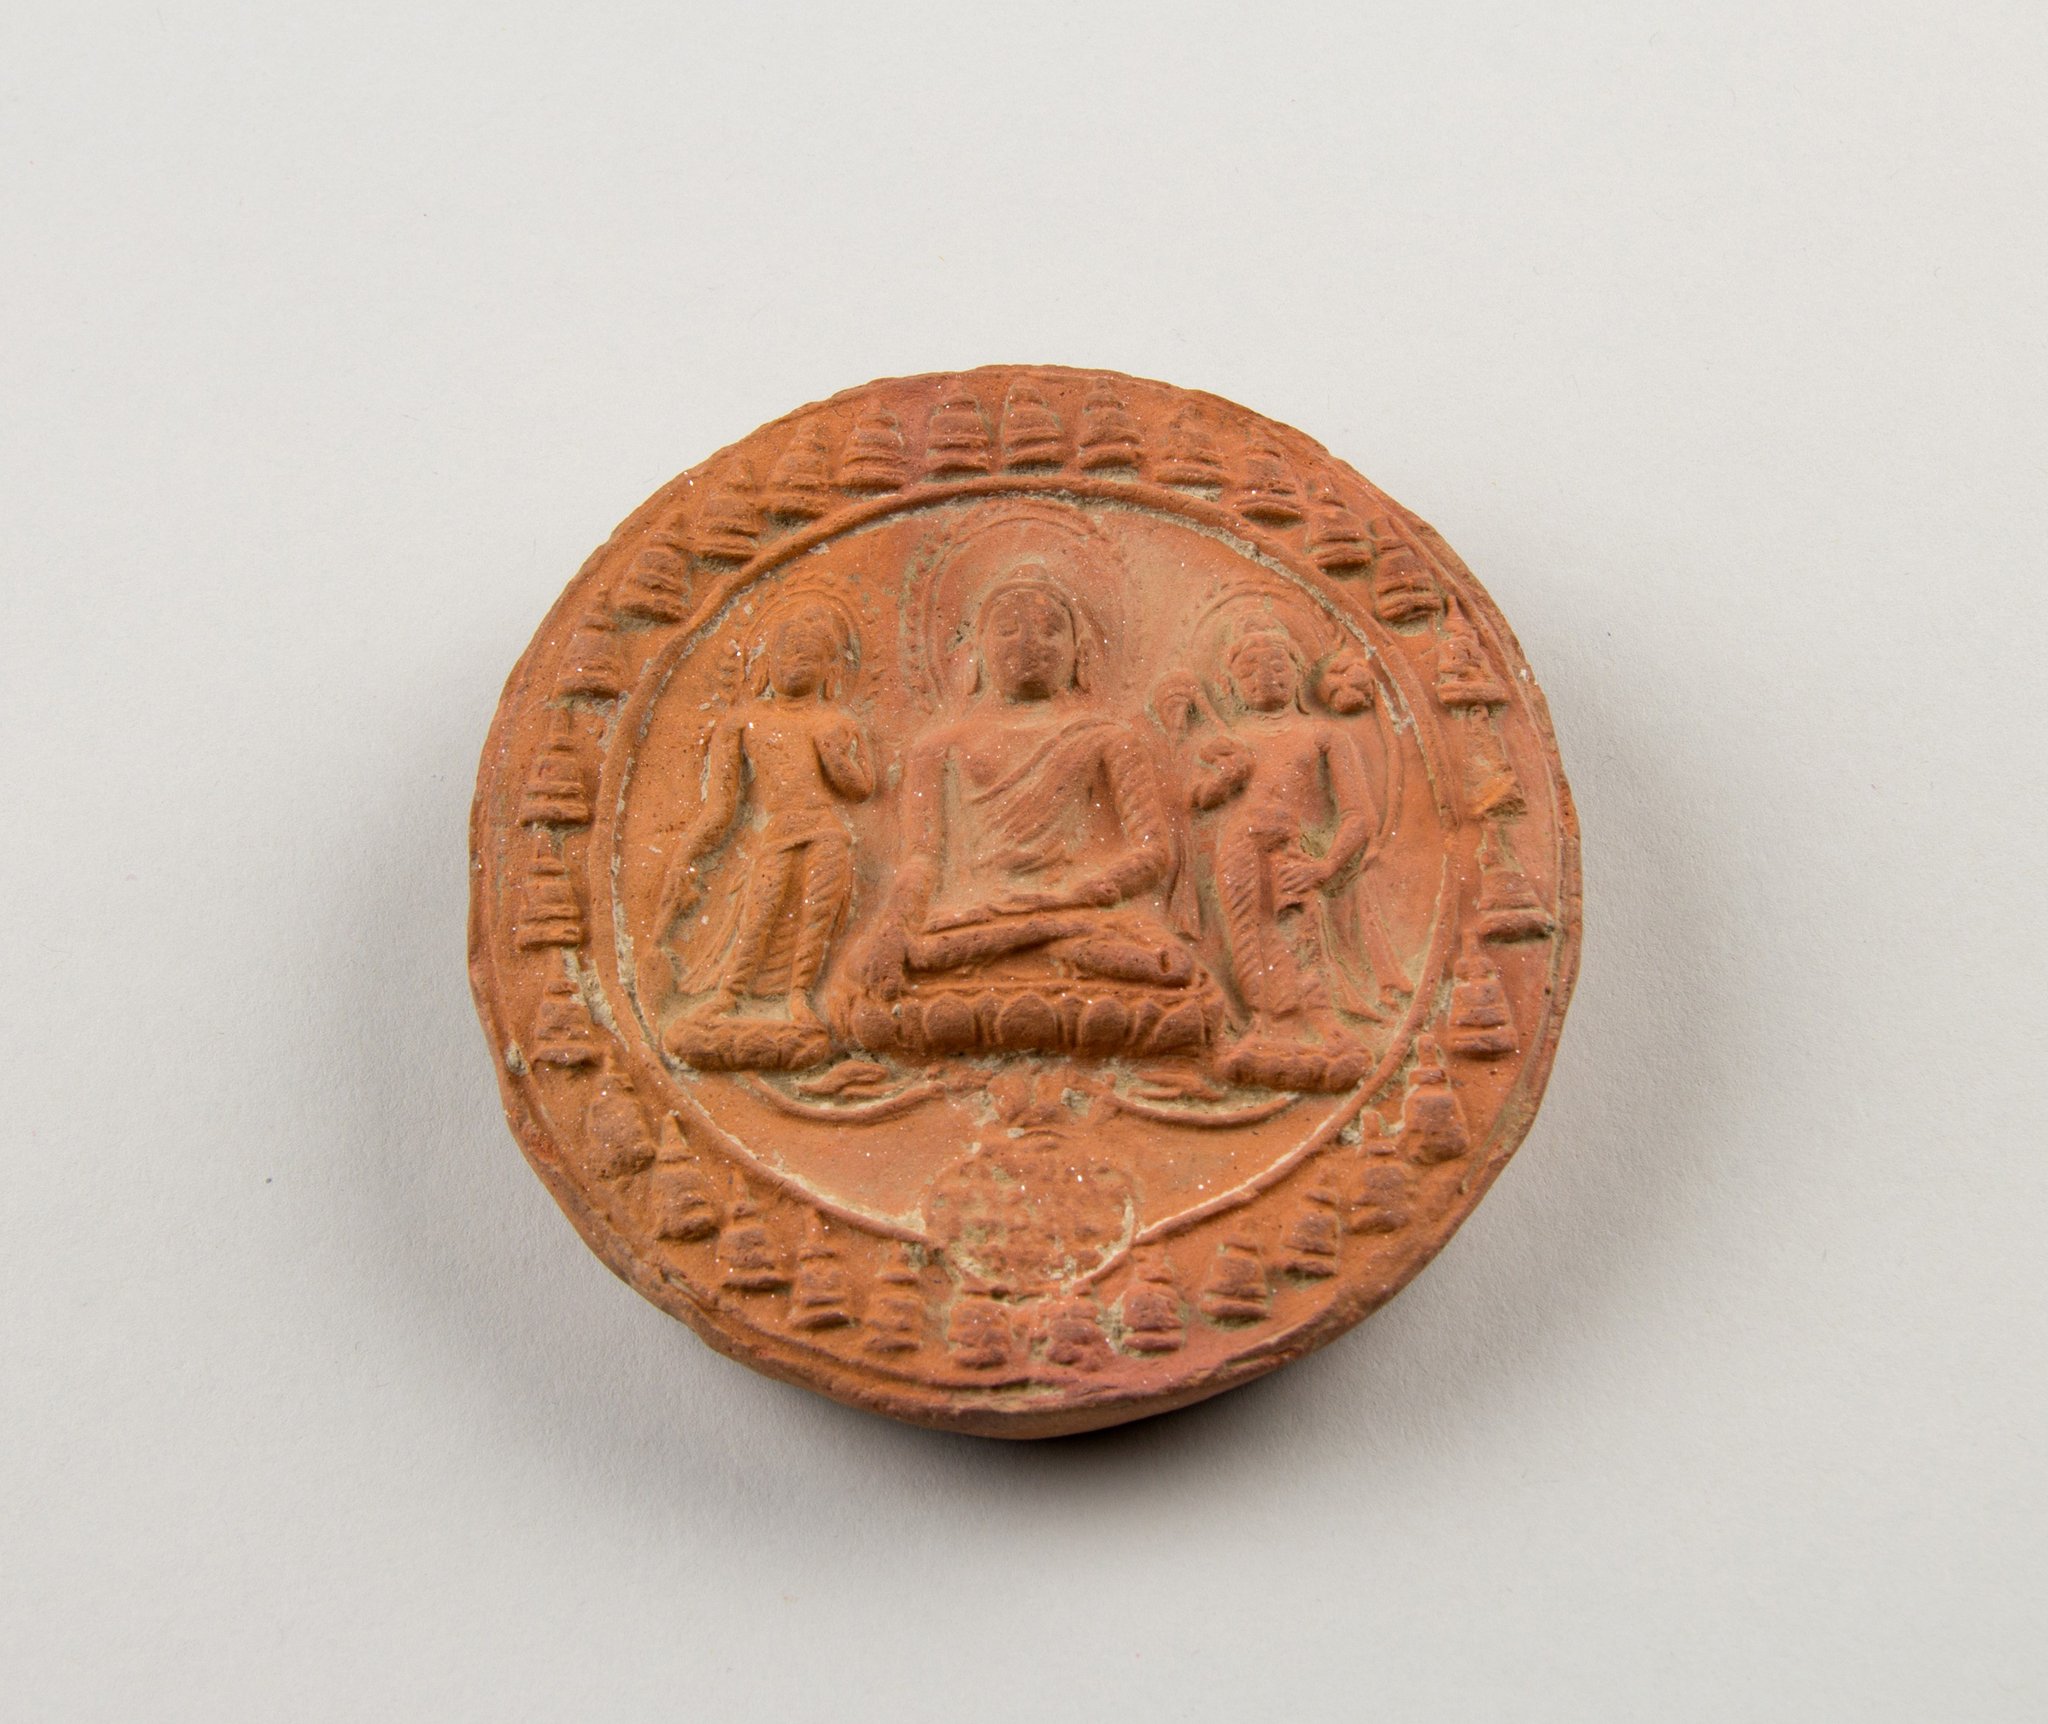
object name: plaque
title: Molded Plaque with Seated Buddha and Attendant Bodhisattvas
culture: indian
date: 1001-1100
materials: terracotta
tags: buddhism,bodhisattvas,buddha